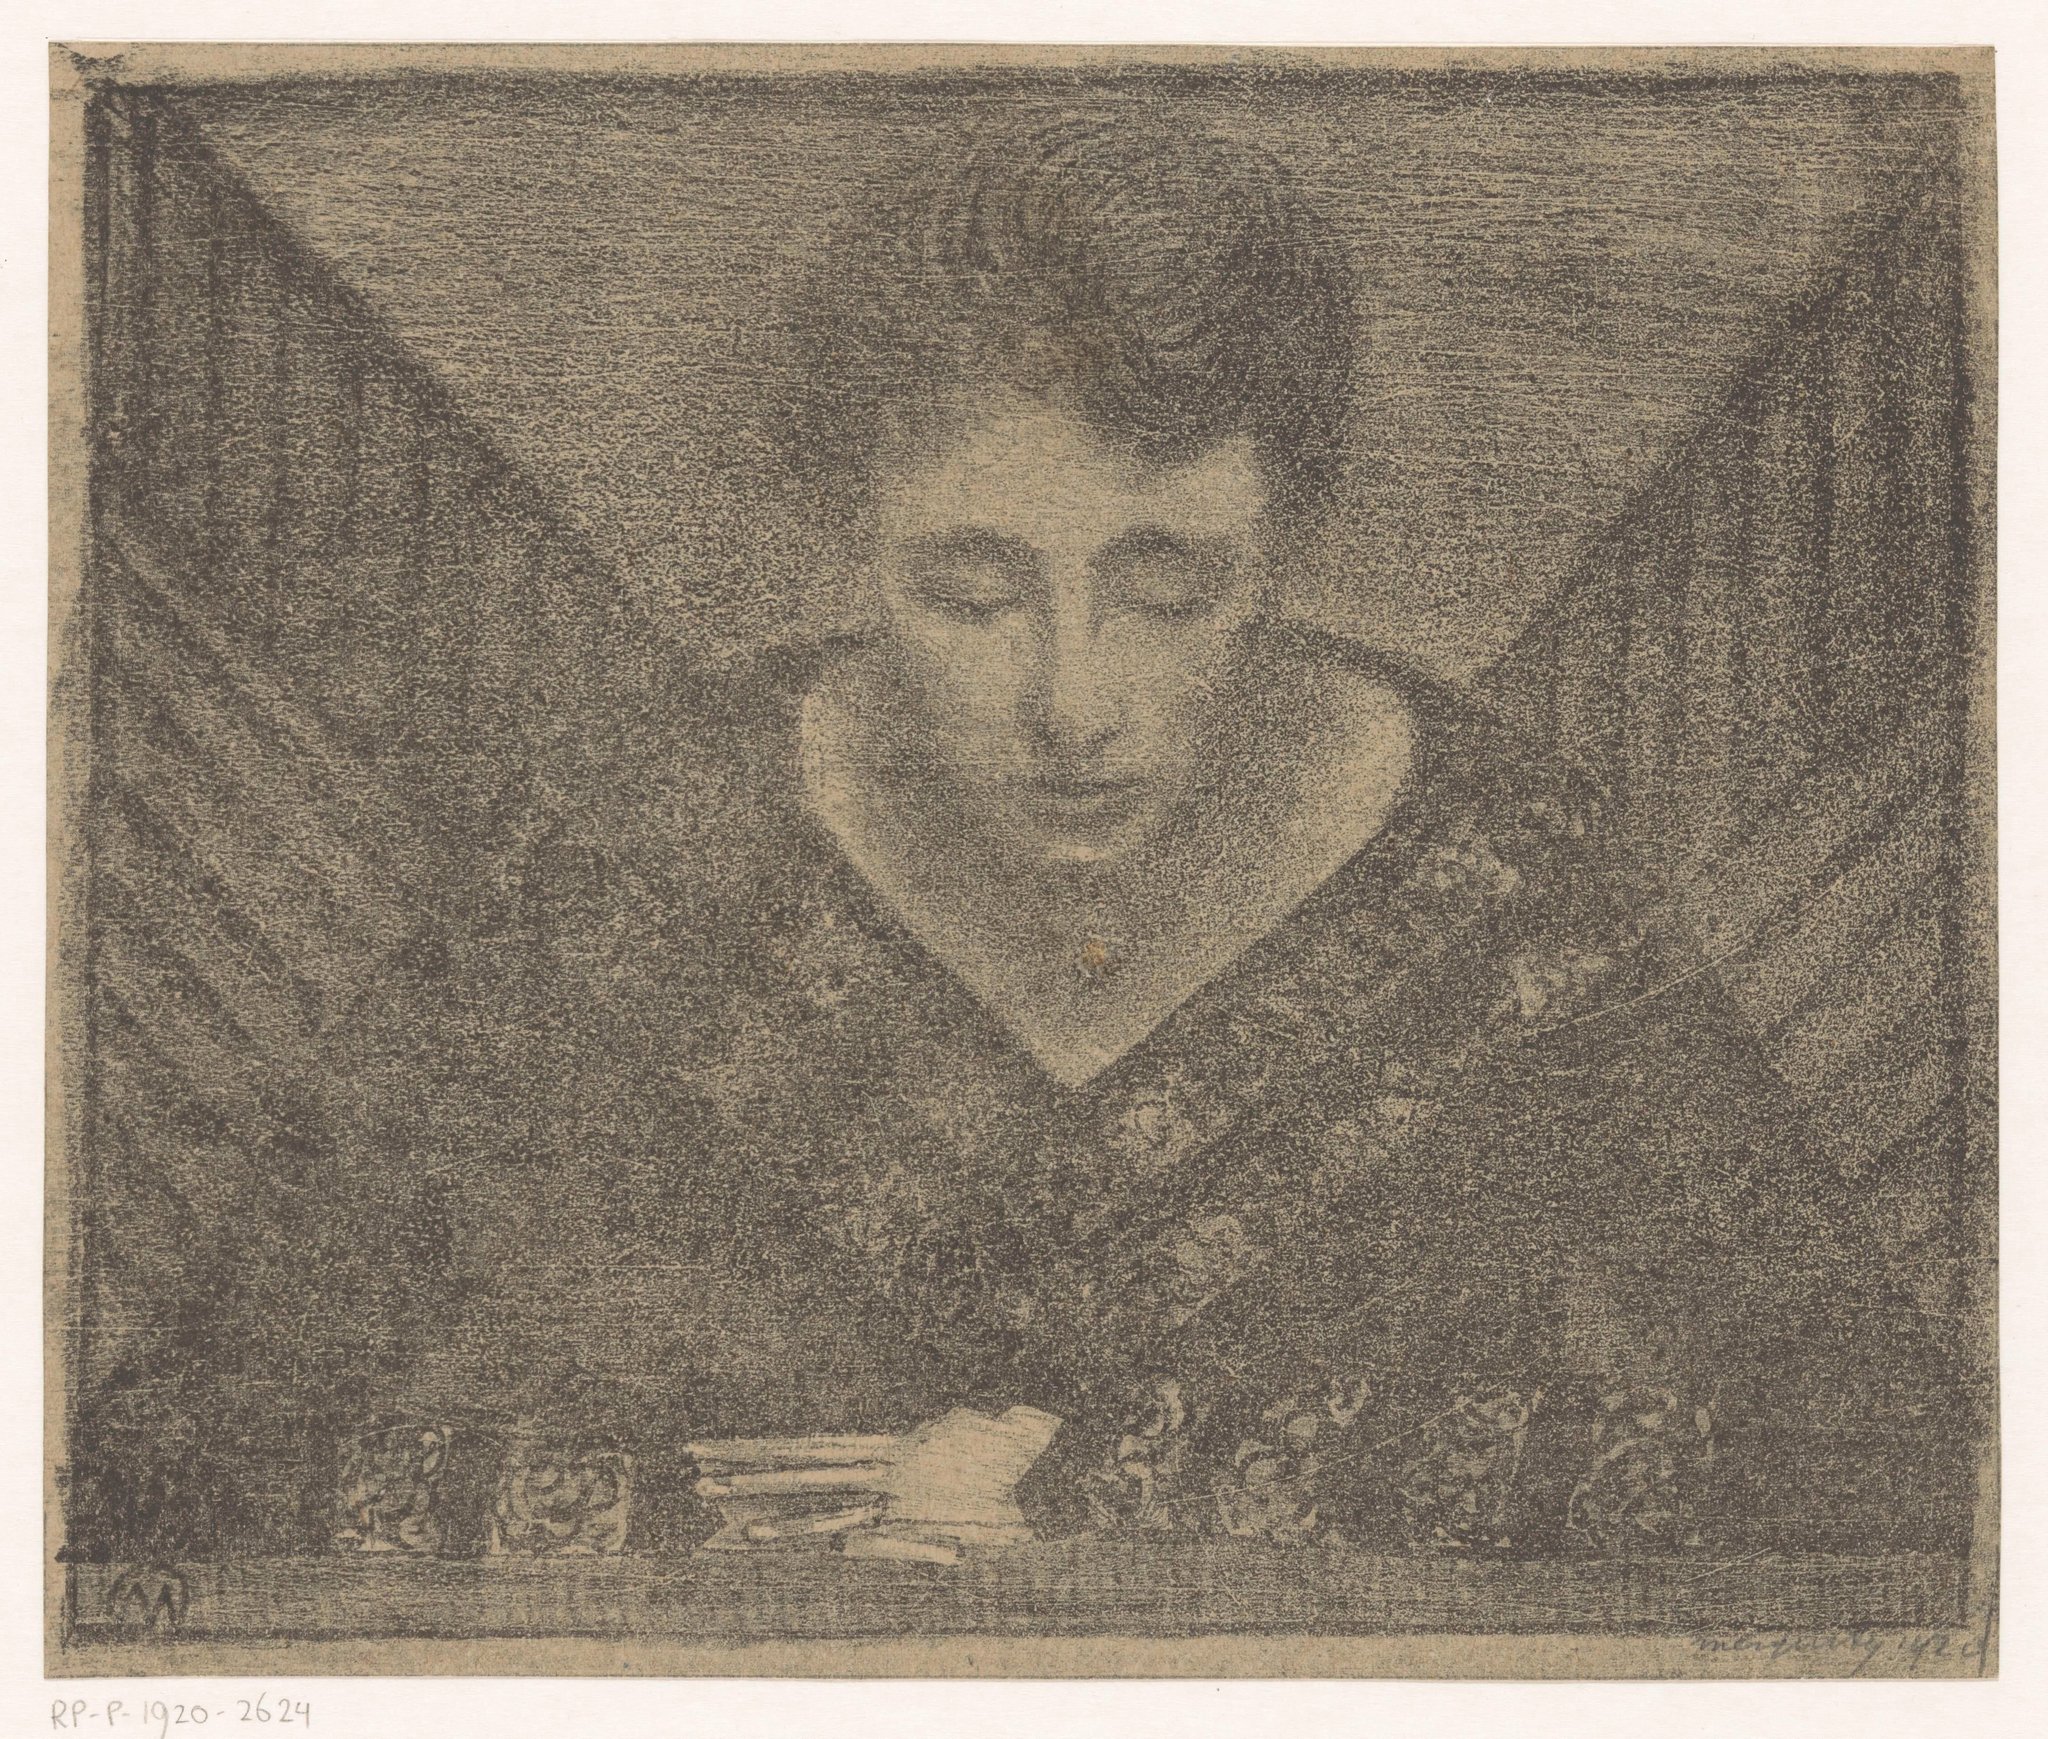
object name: print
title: Vrouw met V-hals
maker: samuel jessurun de mesquita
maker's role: draughtsman, print maker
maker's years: 1868-1944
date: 1920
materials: paper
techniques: lithograph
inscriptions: signature and date: ‘mesquita 1920’